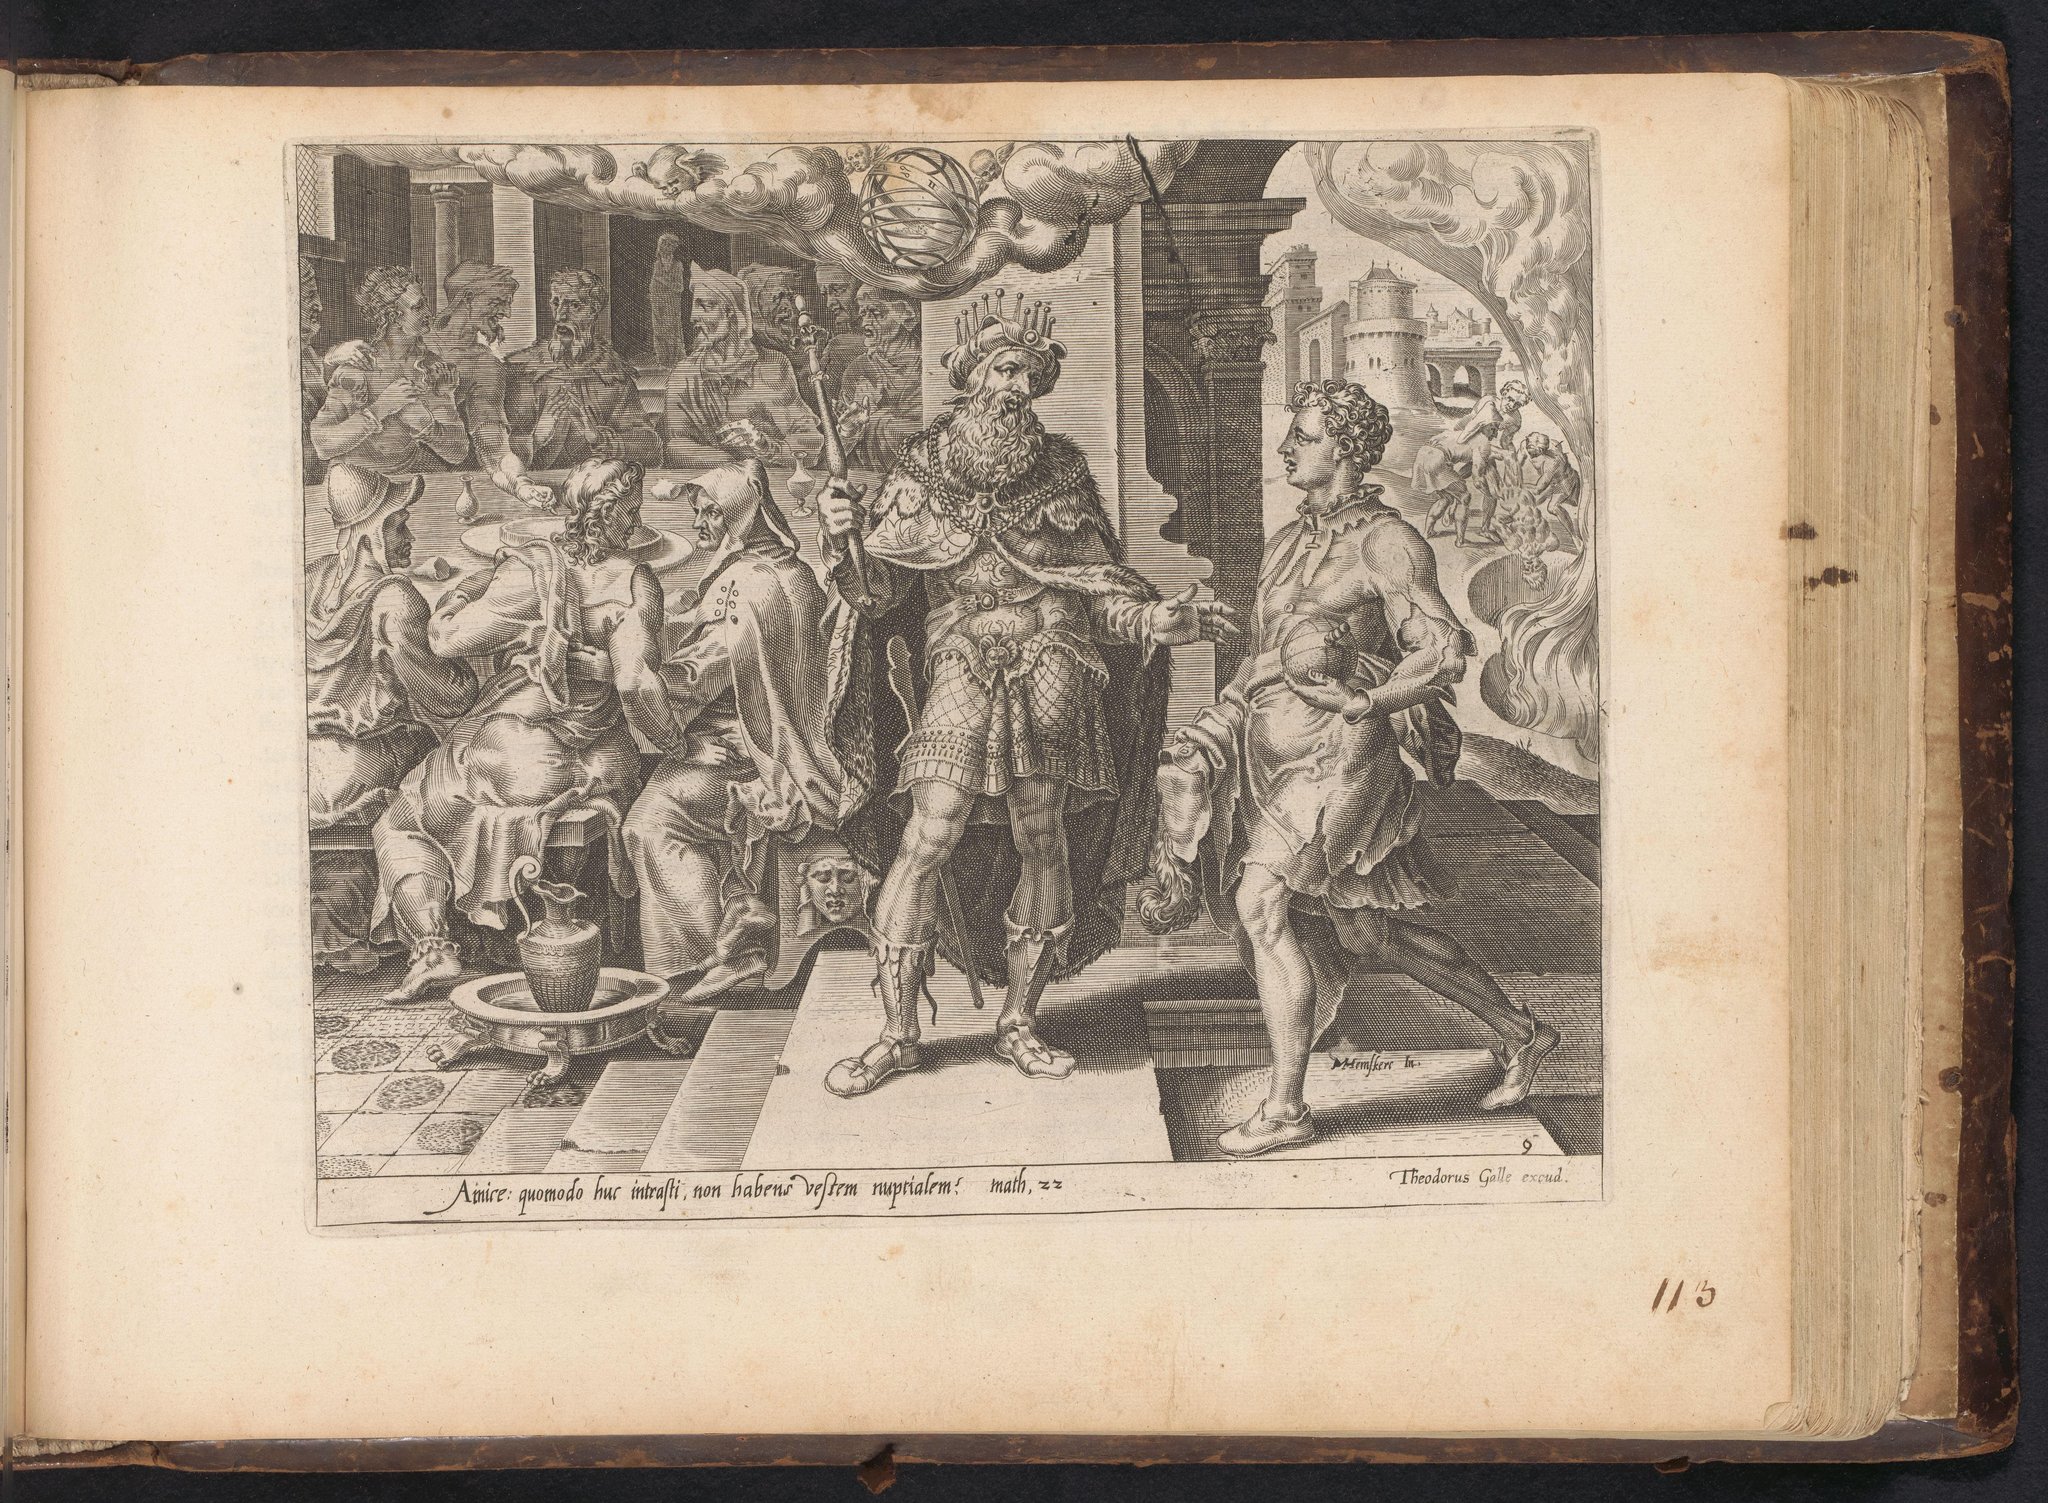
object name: album leaf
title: Den Grooten Figuer-Bibel (...)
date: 1558-1559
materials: paper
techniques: engraving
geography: alkmaar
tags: the king sees a guest without a wedding garment: 'bind him hand and foot .. and cast him into the outer darkness' ~ parable of the royal wedding-feast, the unworthy guest is dragged out ~ parable of the royal wedding-feast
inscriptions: serial number: ‘9’, number: ‘113’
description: Aan tafel zitten de genodigden van de koning aan het bruiloftsmaal. Een man zonder bruiloftskleren wilt zich bij het bruiloftsfeest voegen maar wordt tegengehouden door de koning. Op de achtergrond wordt de man gestraft door hem in het hellevuur te gooien. Onder de voorstelling een verwijzing in het Latijn naar de Bijbeltekst in Mat. 22. Deze prent maakt deel uit van een album.